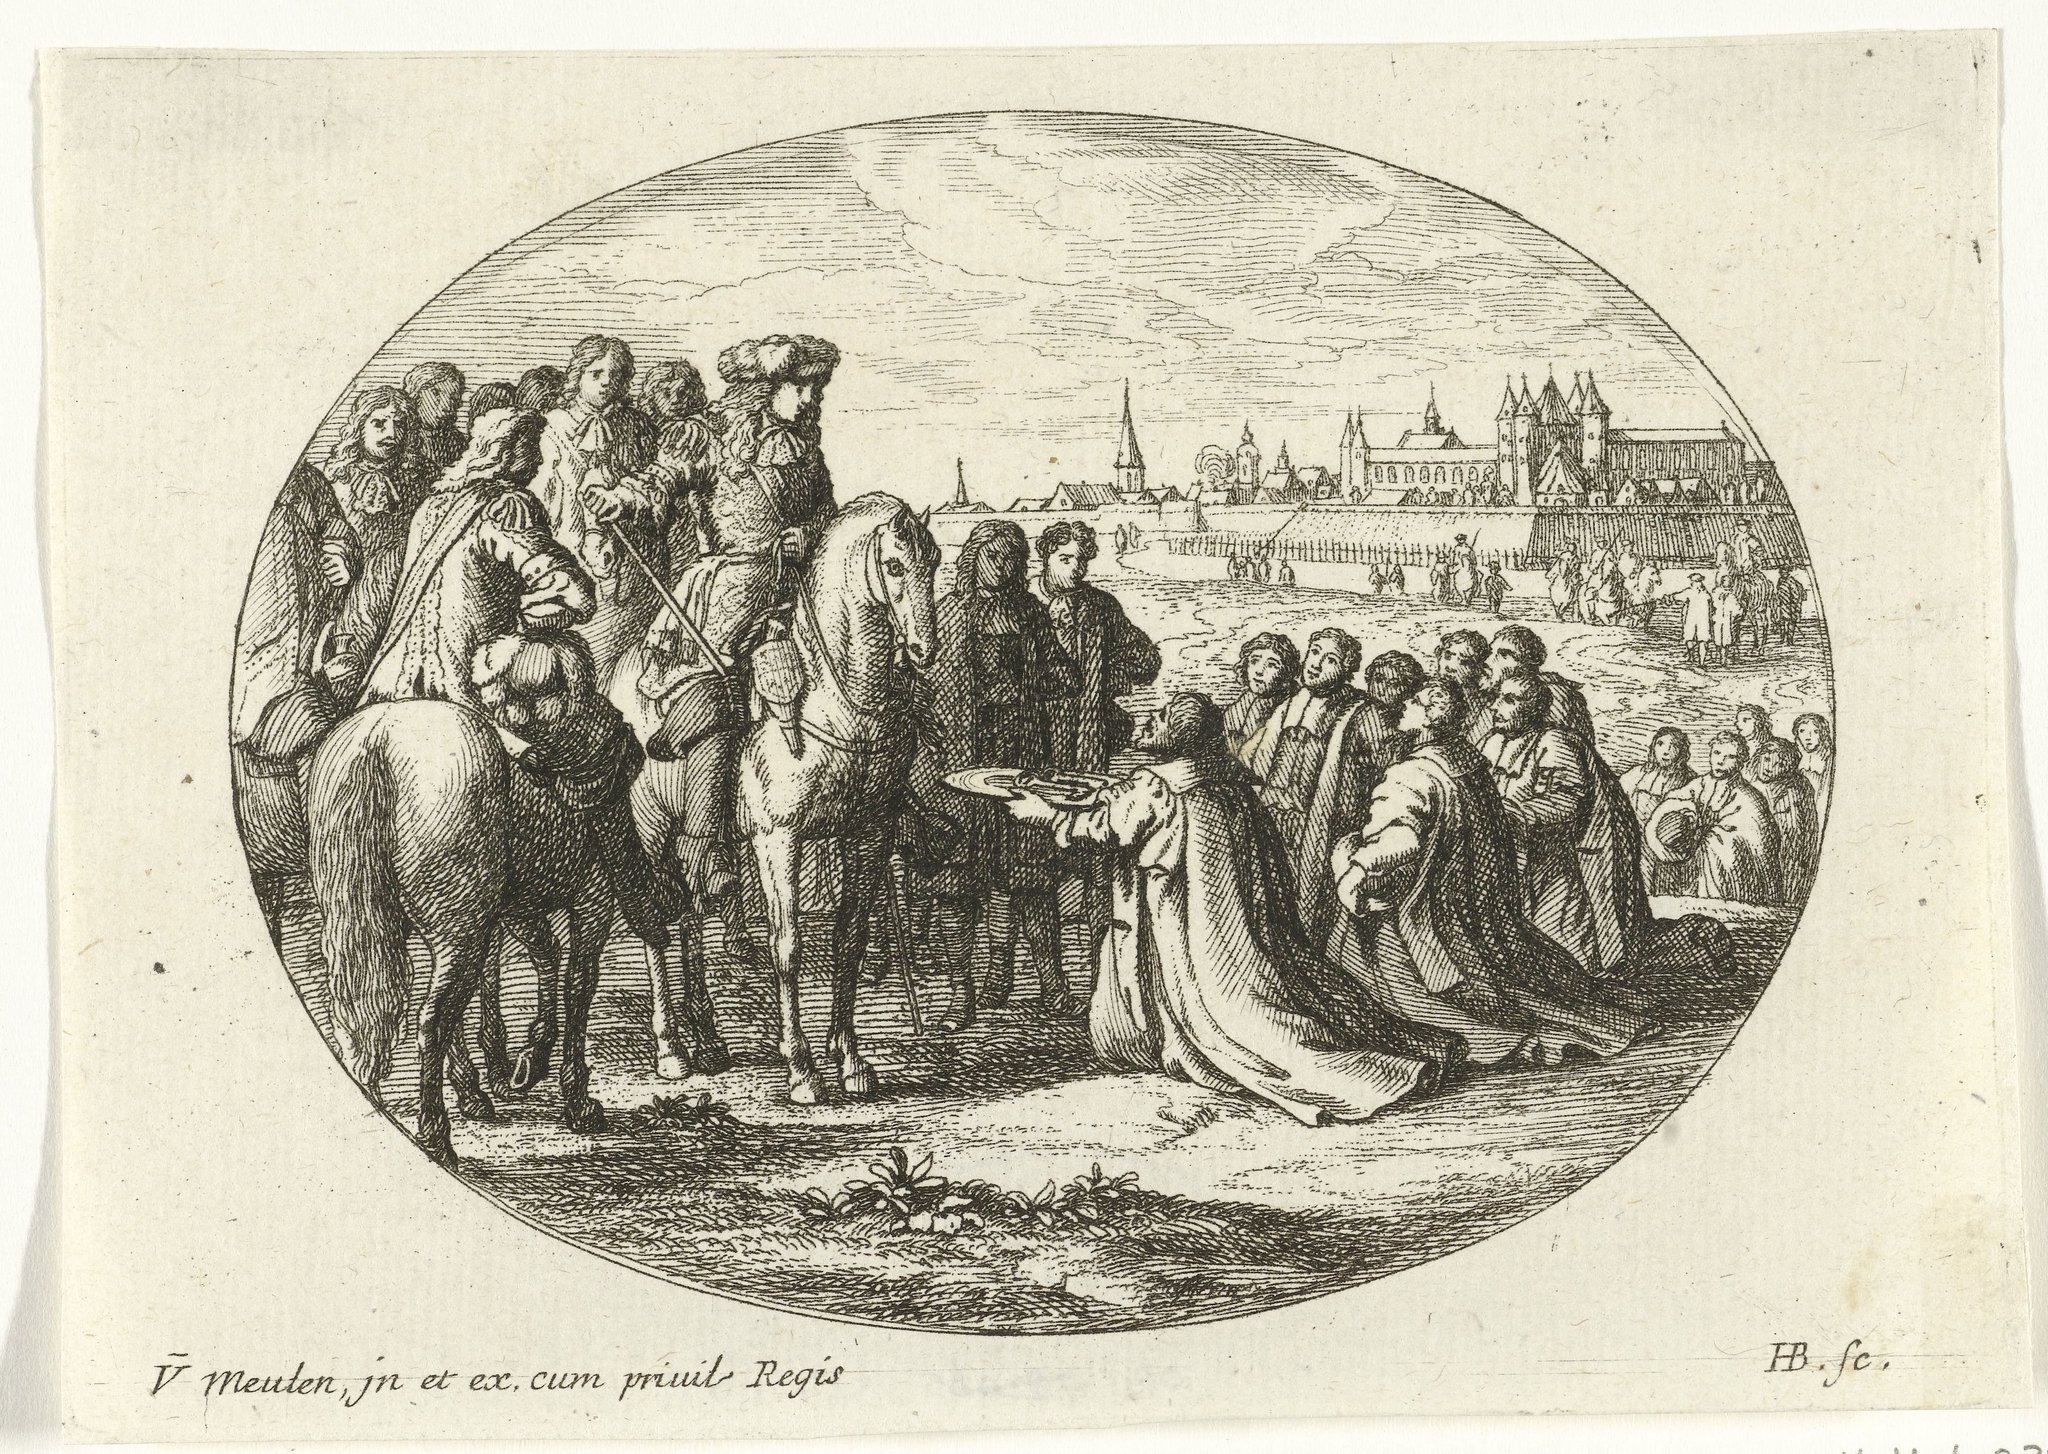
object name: print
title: Stadssleutels worden aangeboden aan Lodewijk XIV, koning van Frankrijk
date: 1674-1733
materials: paper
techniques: etching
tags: lodewijk xiv (koning van frankrijk), historical persons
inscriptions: collector's mark: Lugt 2228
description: Links Lodewijk XIV met zijn gevolg. Tegenover hem knielen een man met een schaal met daarop twee sleutels en andere heren. Rechtsachter een stad.